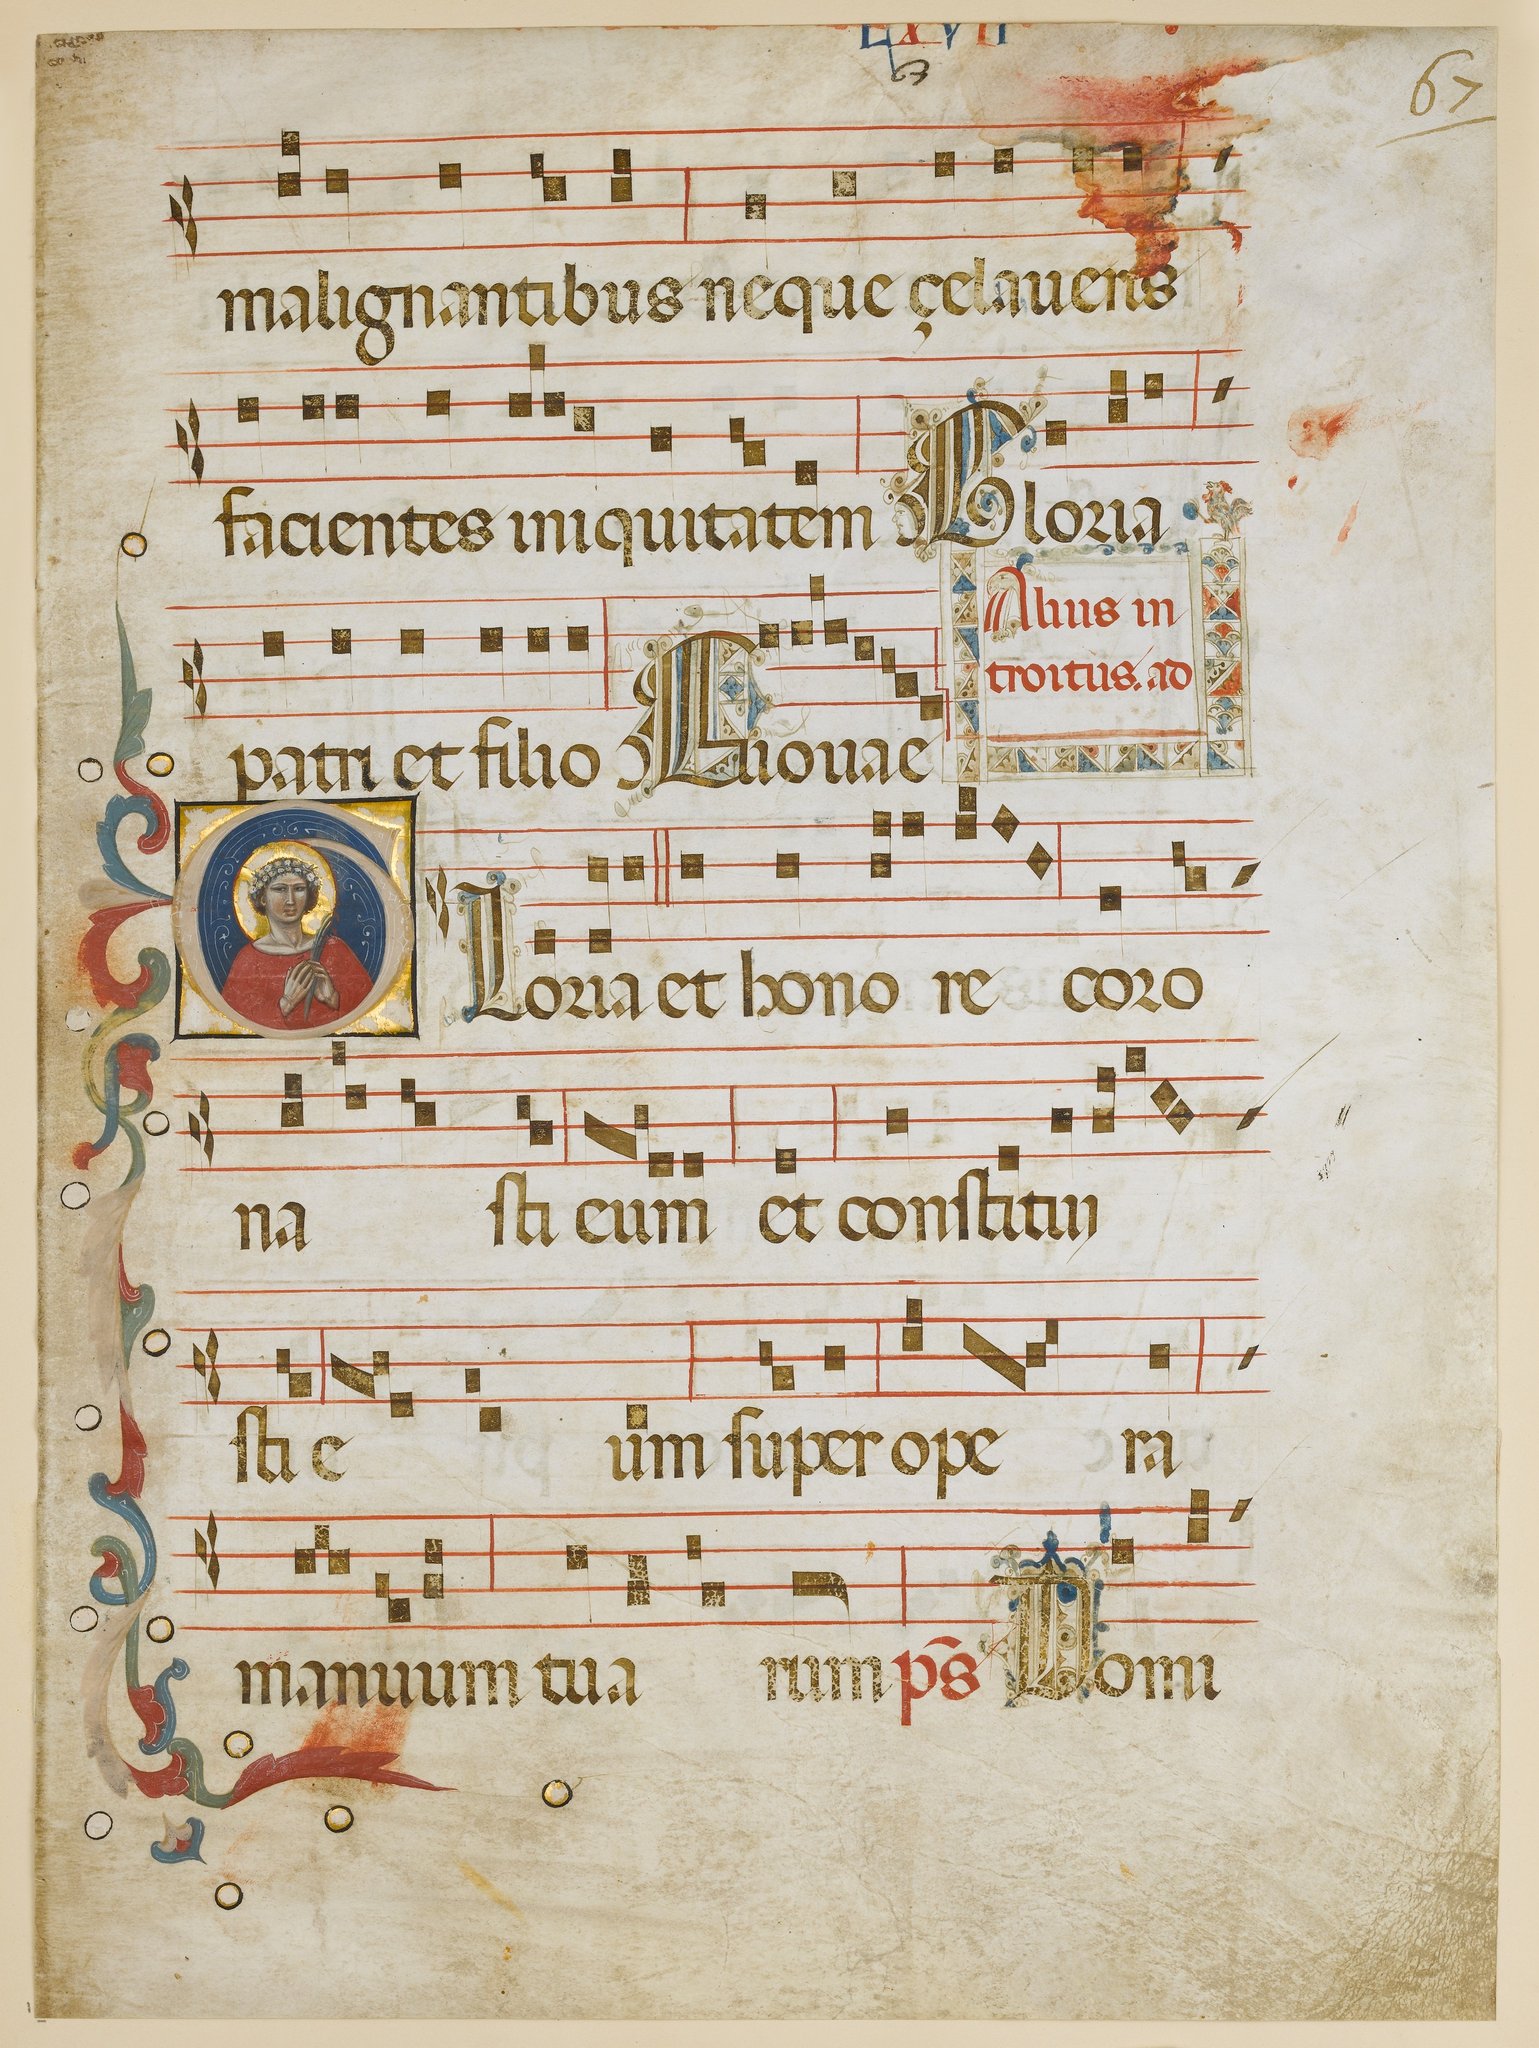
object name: gradual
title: Manuscript Leaf with a female saint (possibly Dorothy) in an Initial G, from a Gradual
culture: italian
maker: the illustratore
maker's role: artist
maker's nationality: italian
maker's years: 1330-1374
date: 1330-1340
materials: gold, ink, parchment, paint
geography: italy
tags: women,saints